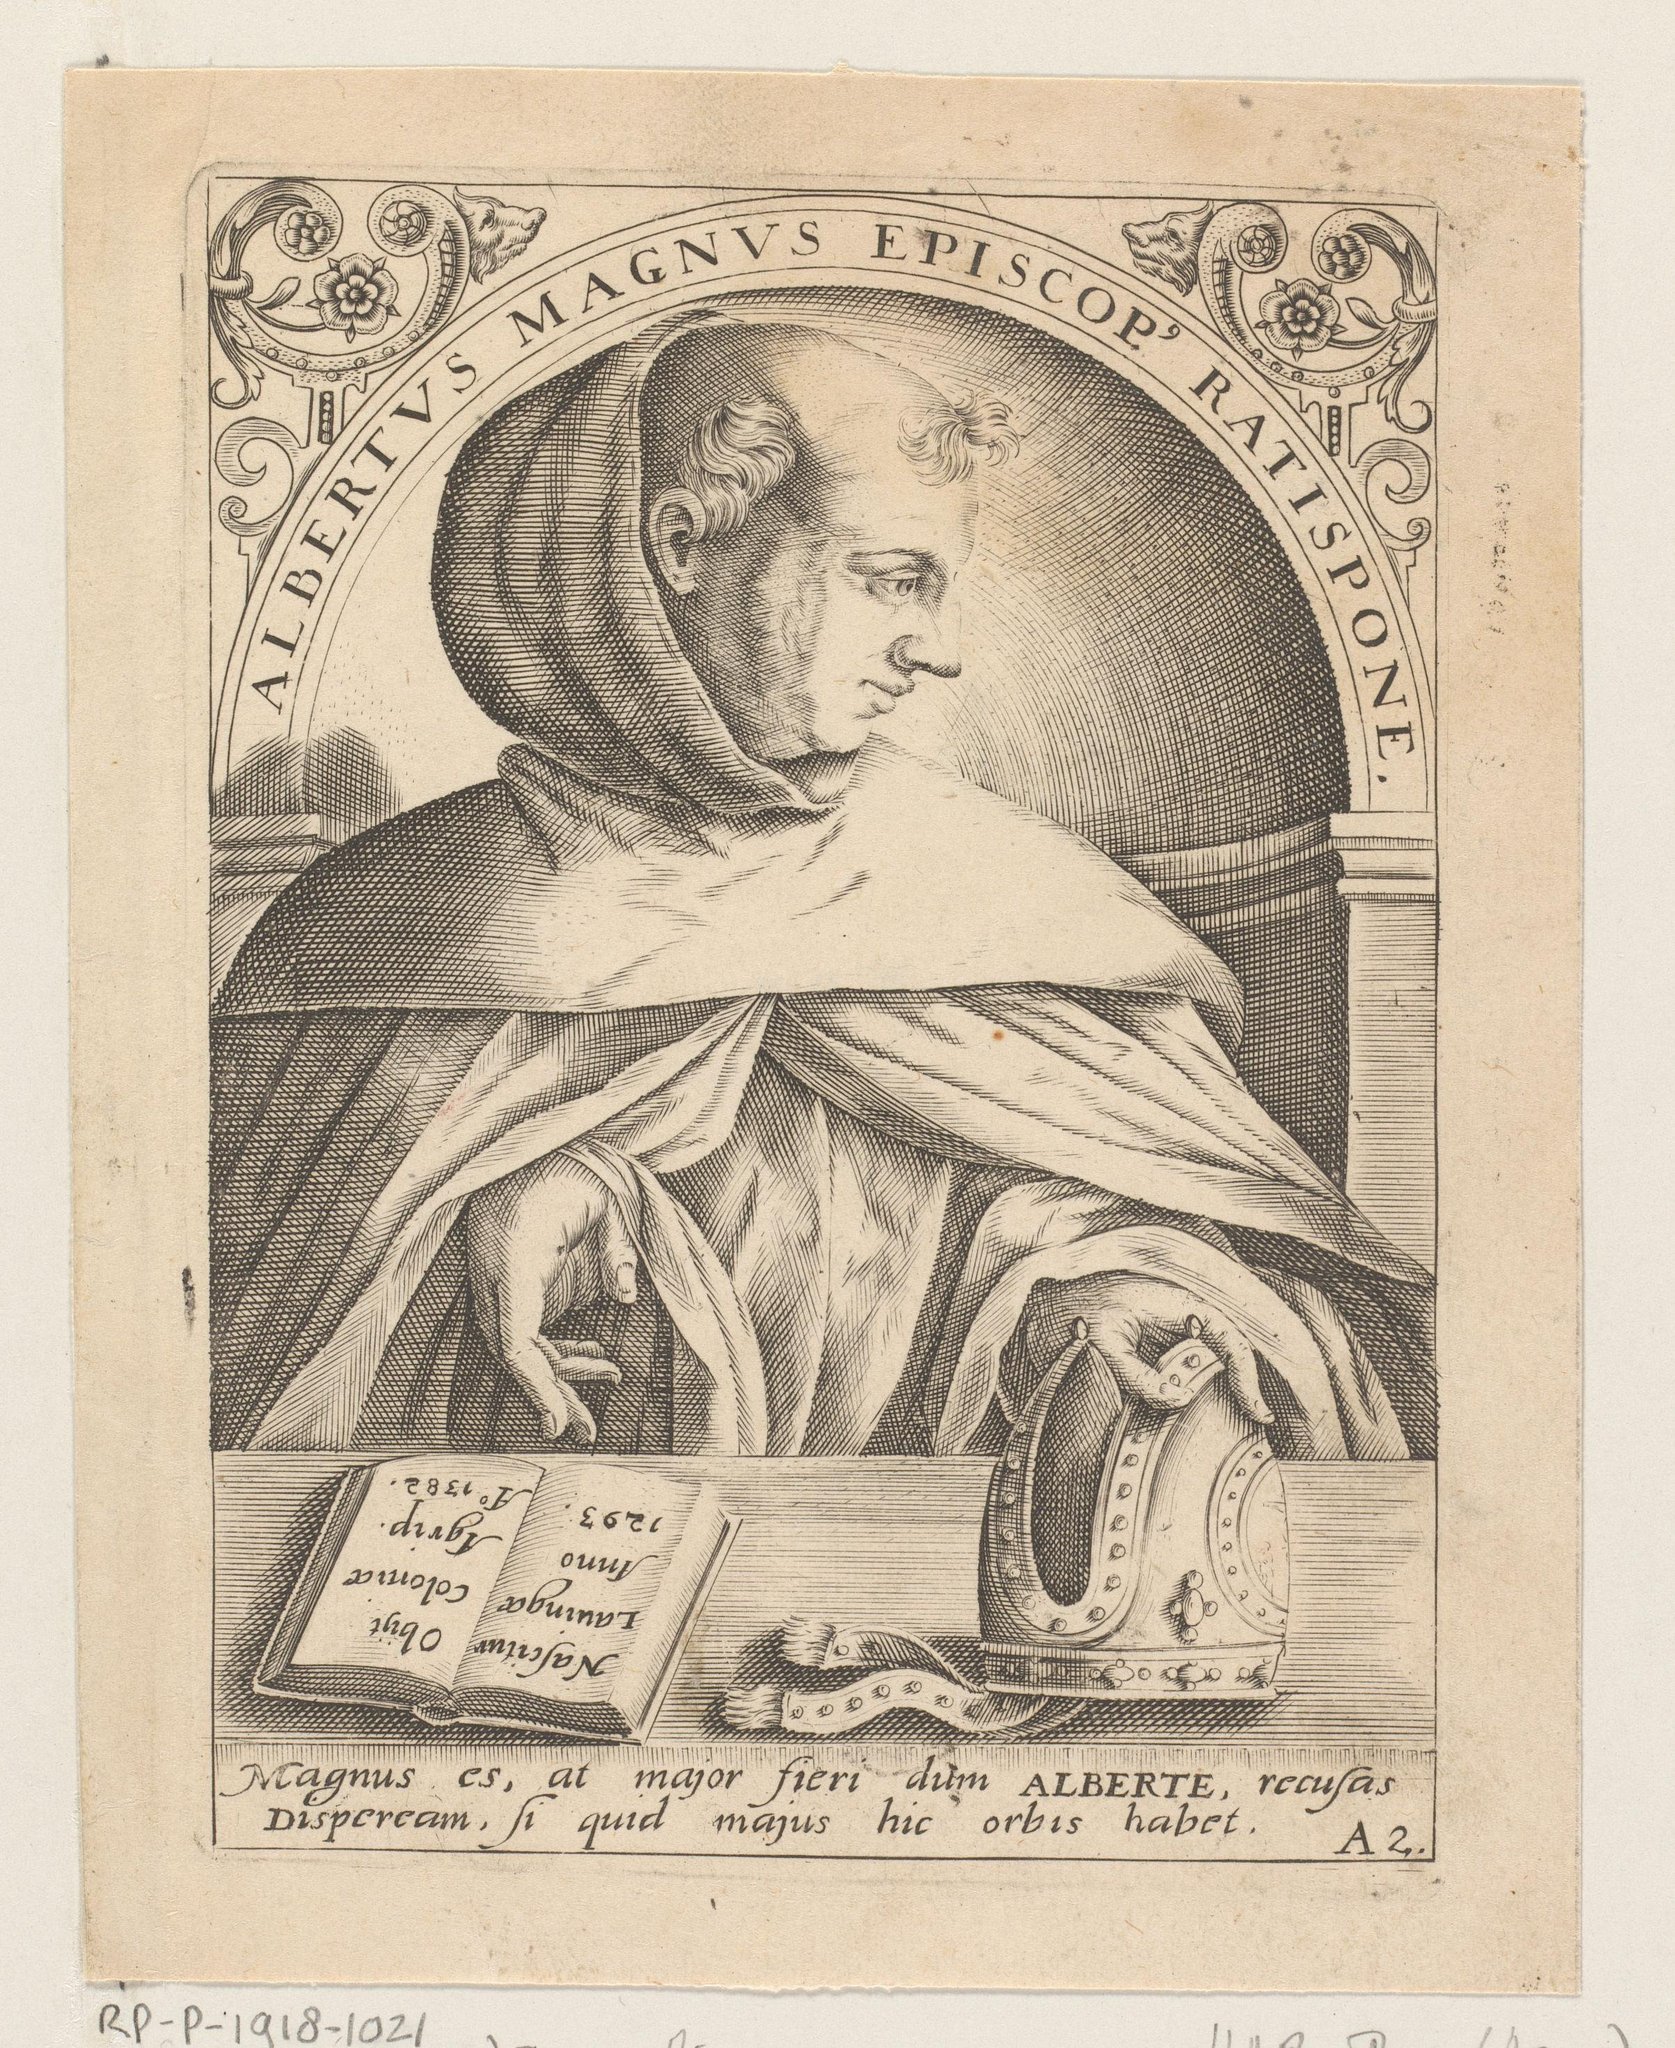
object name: book illustration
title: Albertus Magnus episcop[9] Ratispone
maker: jean jacques boissard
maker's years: 1528-1598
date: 1650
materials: paper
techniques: engraving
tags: cologne, theologian, historical persons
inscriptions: collector's mark: Lugt 2233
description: Prent gebruikt in: Boissard, Jean Jacques. Bibliotheca chalcographica. 8 dln. Frankfurt am Main: Johannes Ammon, 1650-1652. Ook gebruikt in latere edities. Eerdere staat van prent verschenen in: Boissard, Jean Jacques. Icones quinquaginta virorum illustrium doctrina & eruditione praestantium ad vivum effictae. 4 dln. Frankfurt am Main: s.n., 1597-1599. Mogelijk ook gebruikt in latere edities.